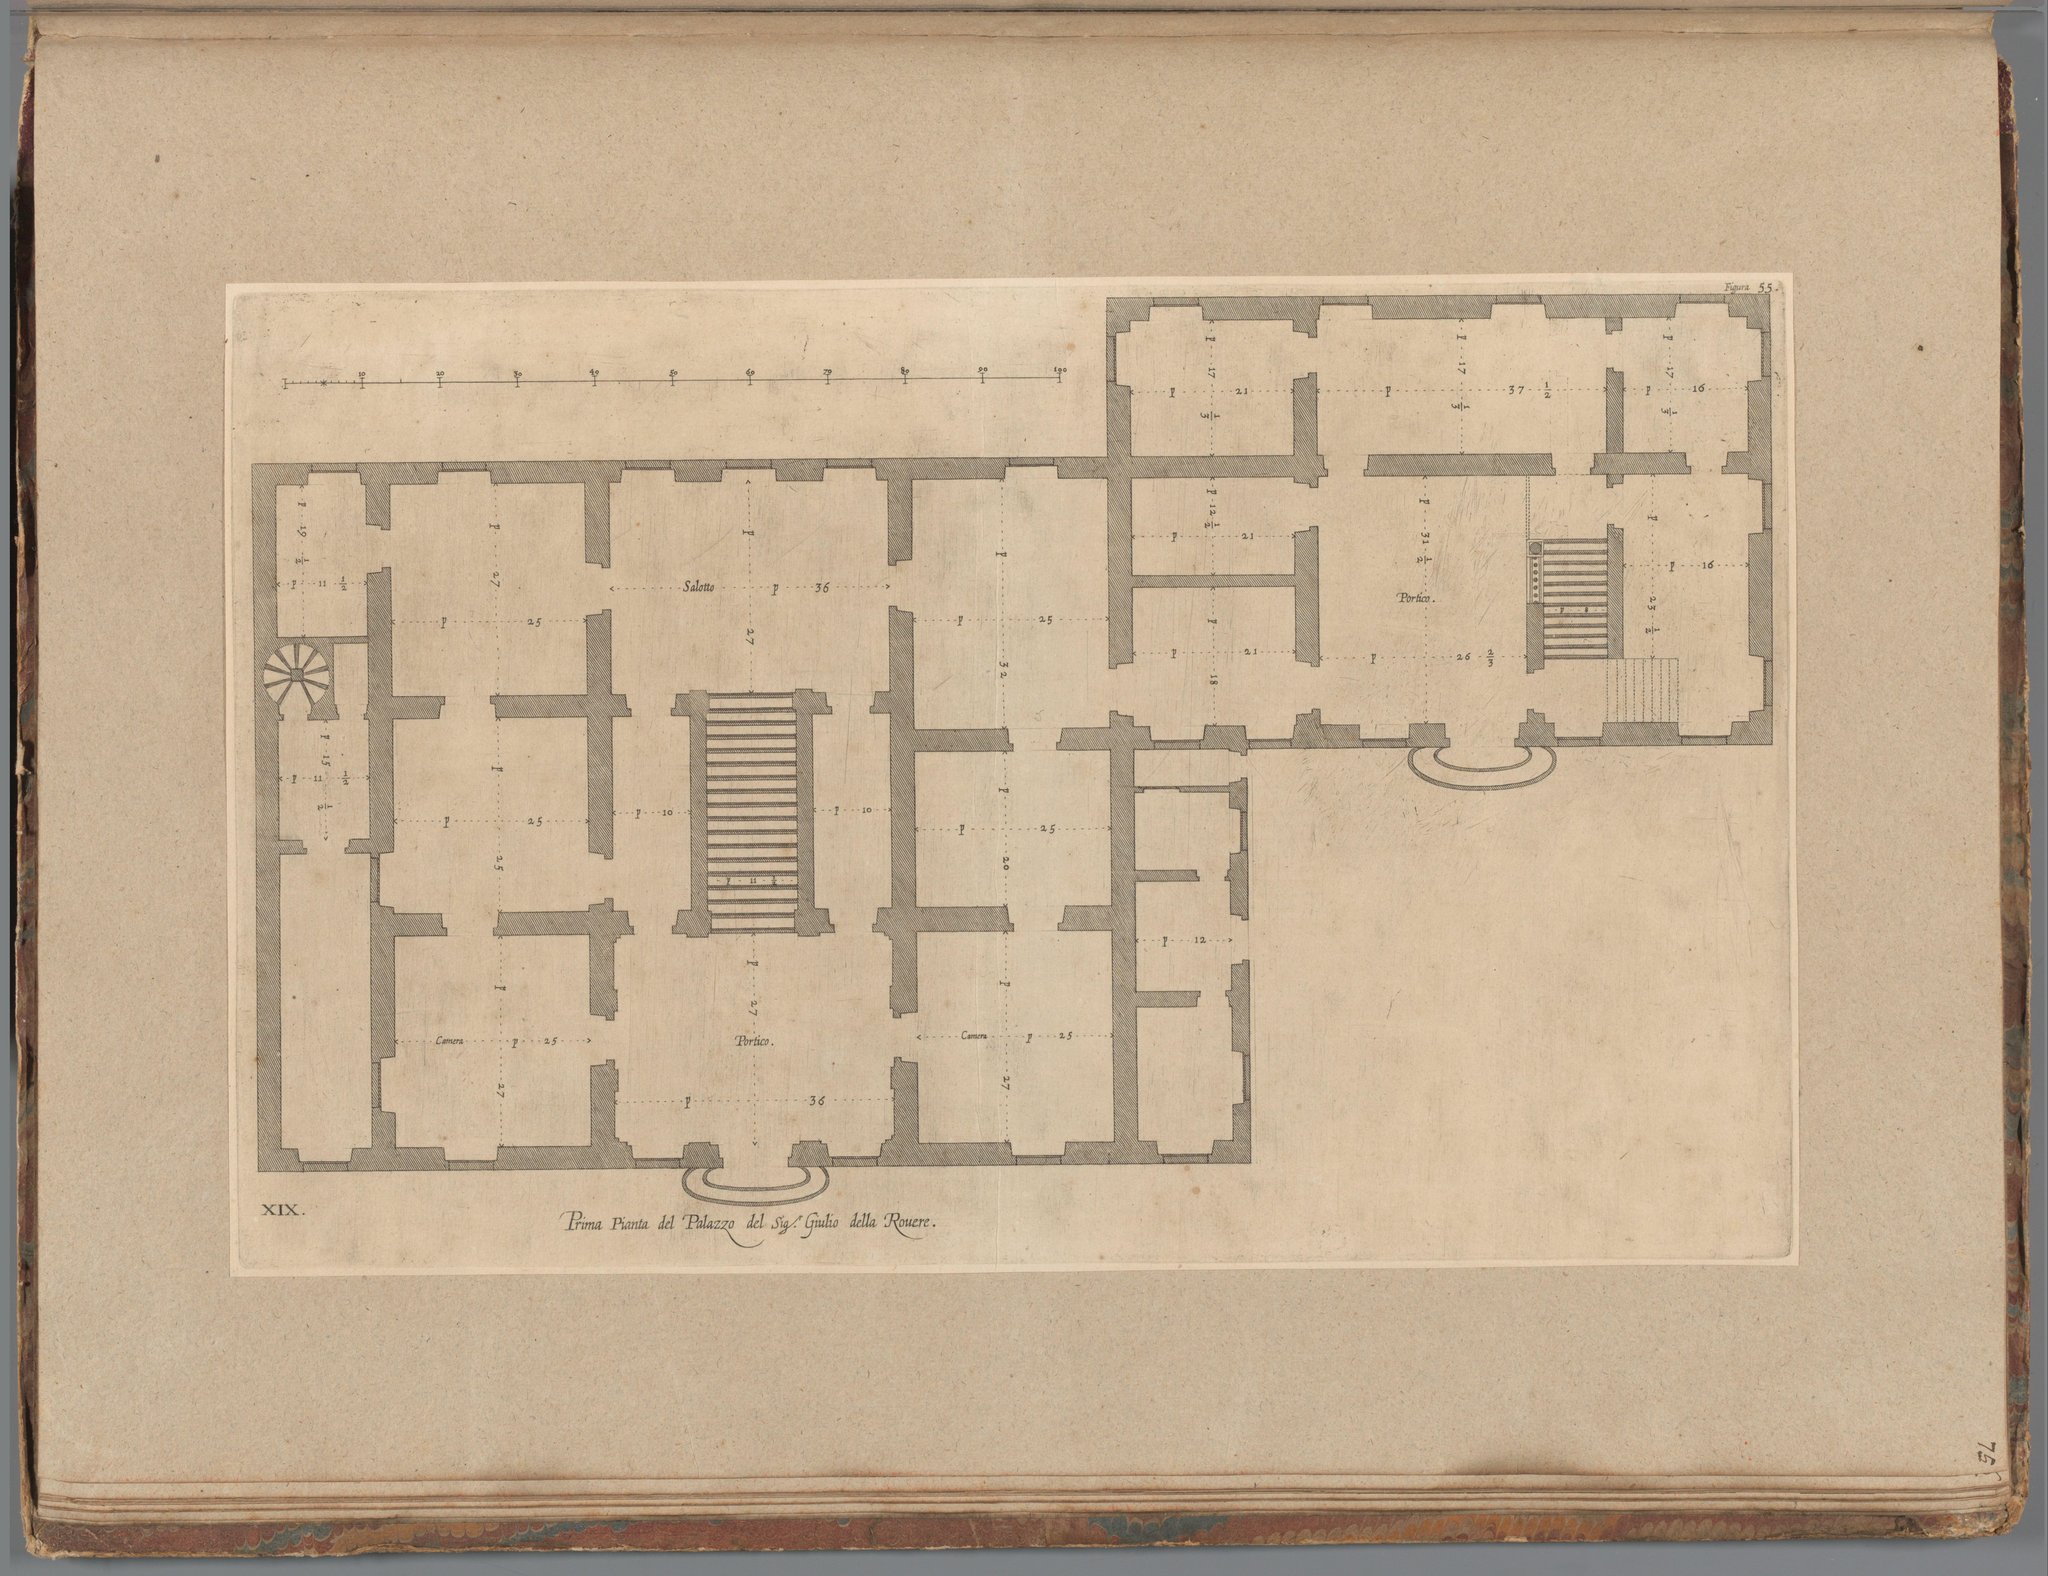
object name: print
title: Prima pianta del Palazzo del sigr. Giulio della Rovere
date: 1622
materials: paper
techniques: engraving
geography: antwerp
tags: hôtel, i.e. small palace in city - aa - civic architecture: inside, plan ~ architecture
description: Deze prent maakt deel uit van een album.